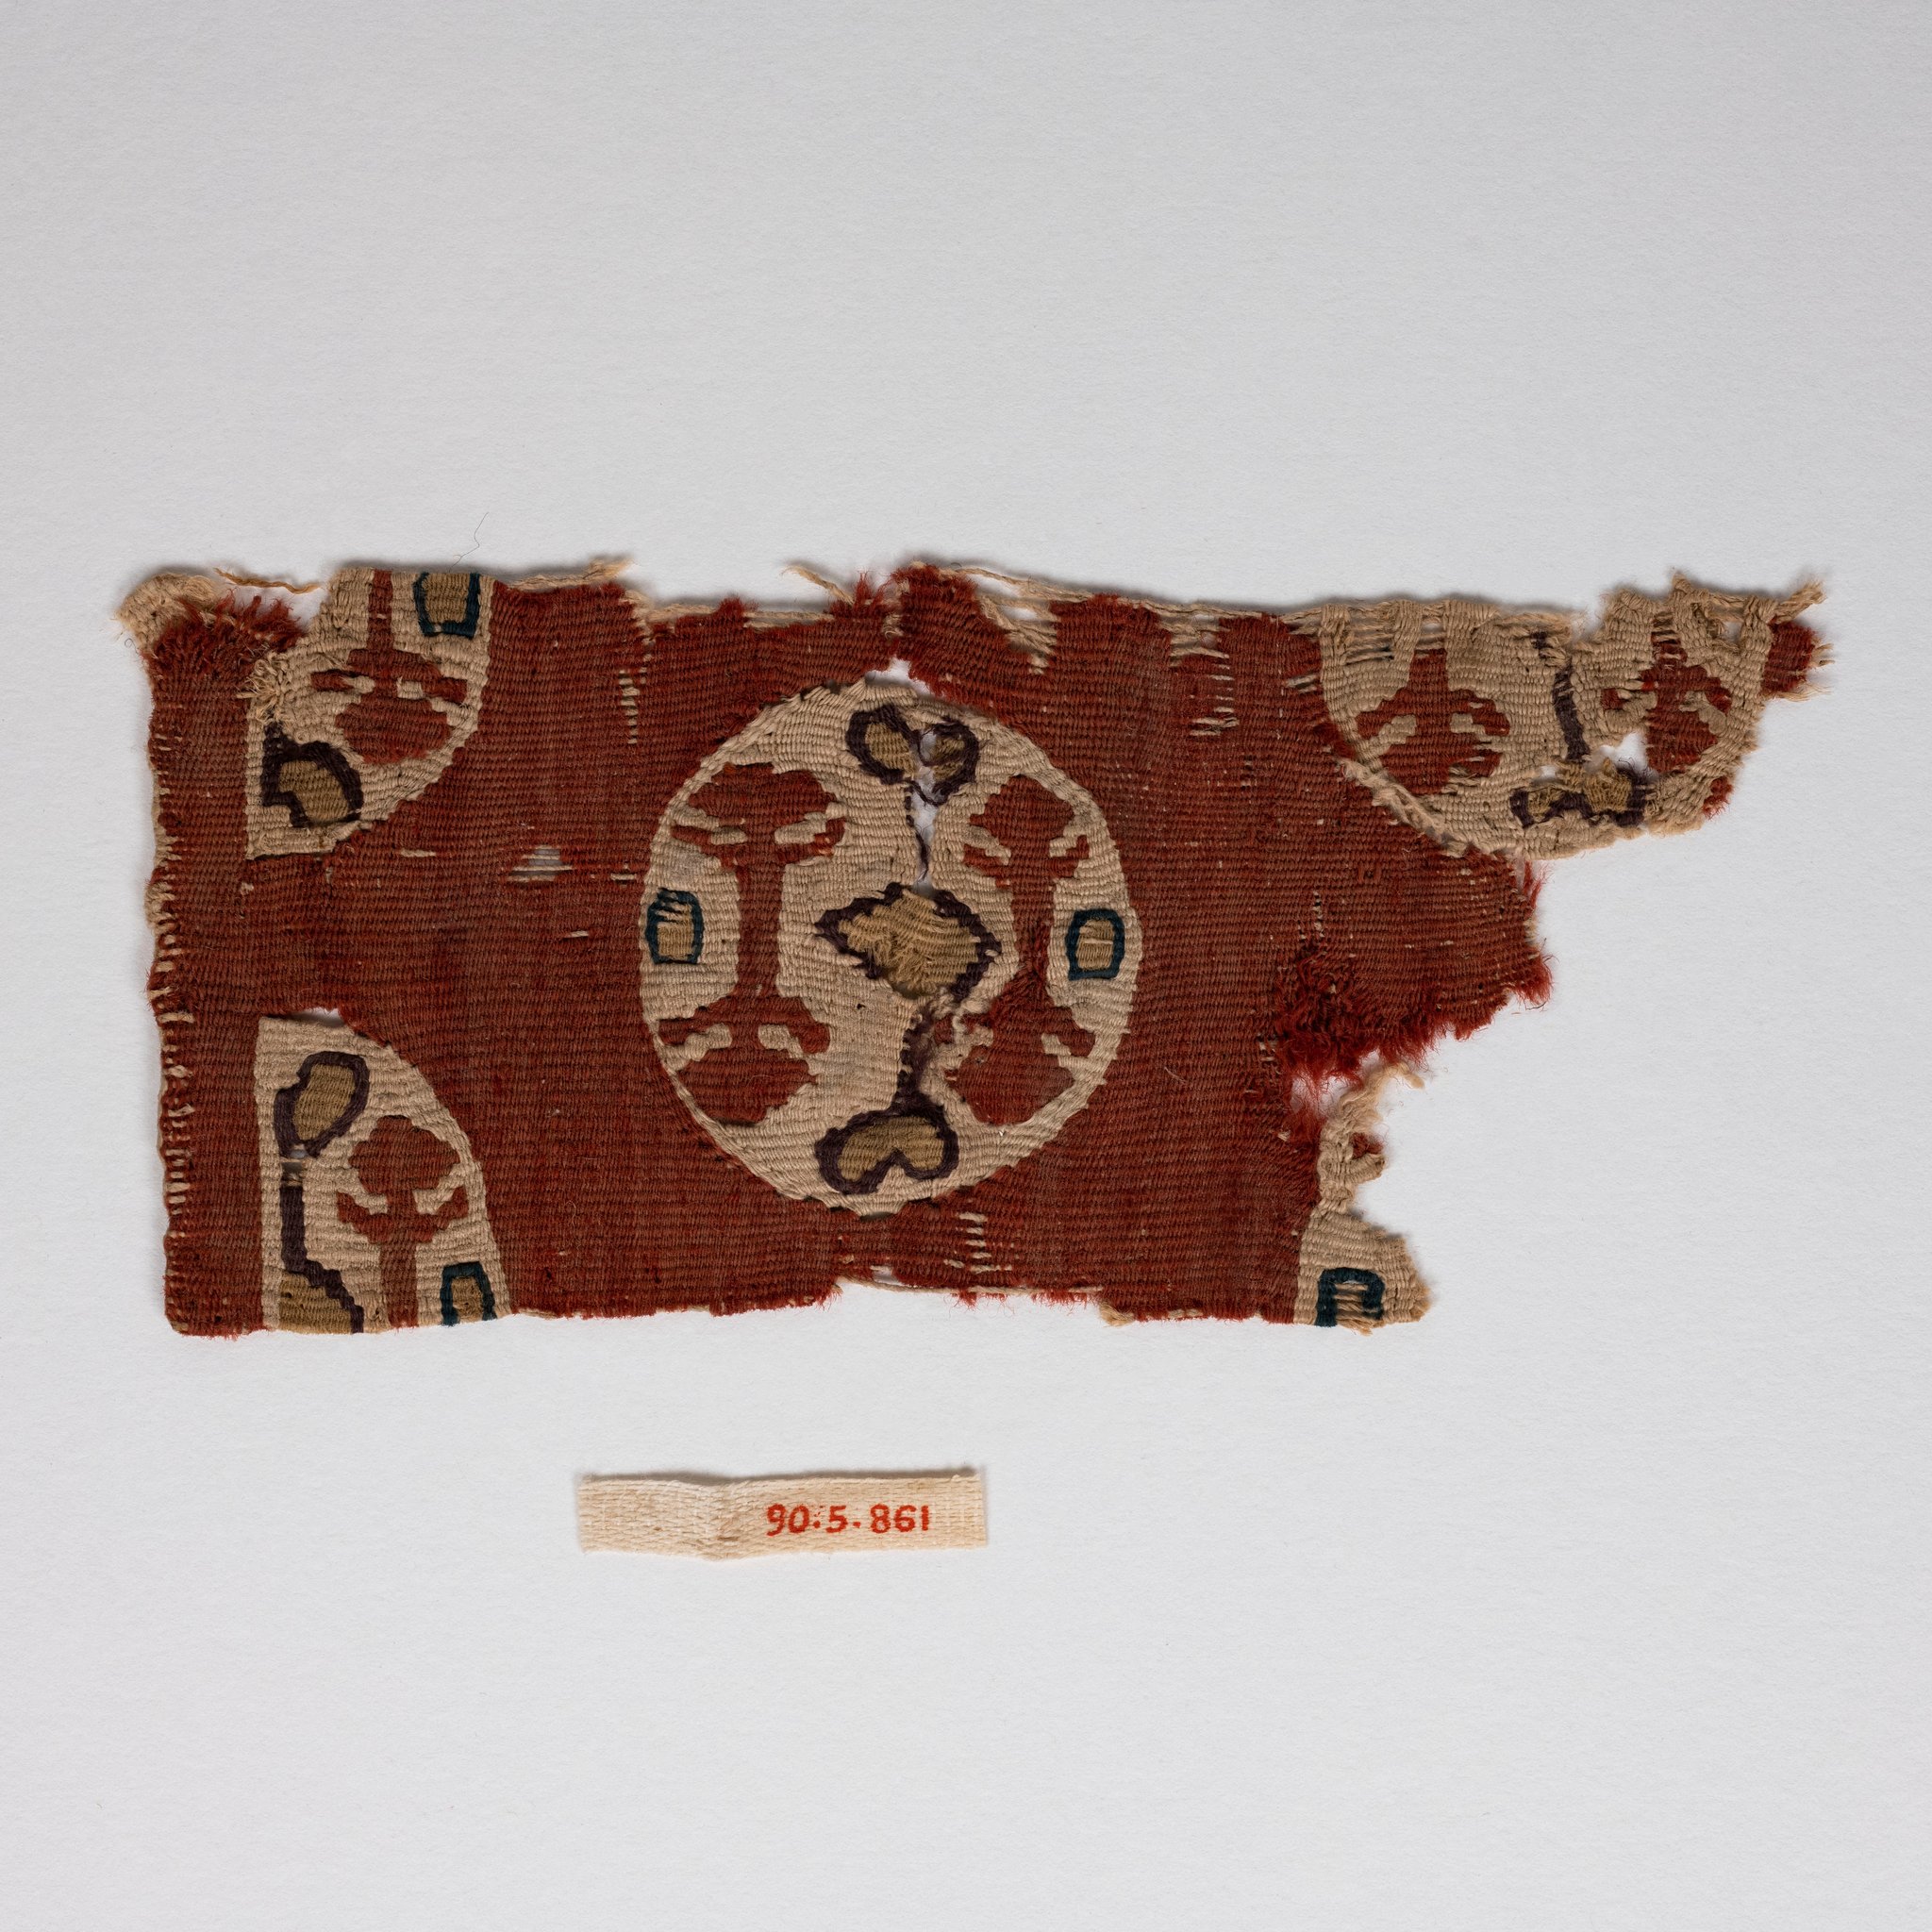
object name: textile fragment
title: Fragment of a Band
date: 501-700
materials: wool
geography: egypt